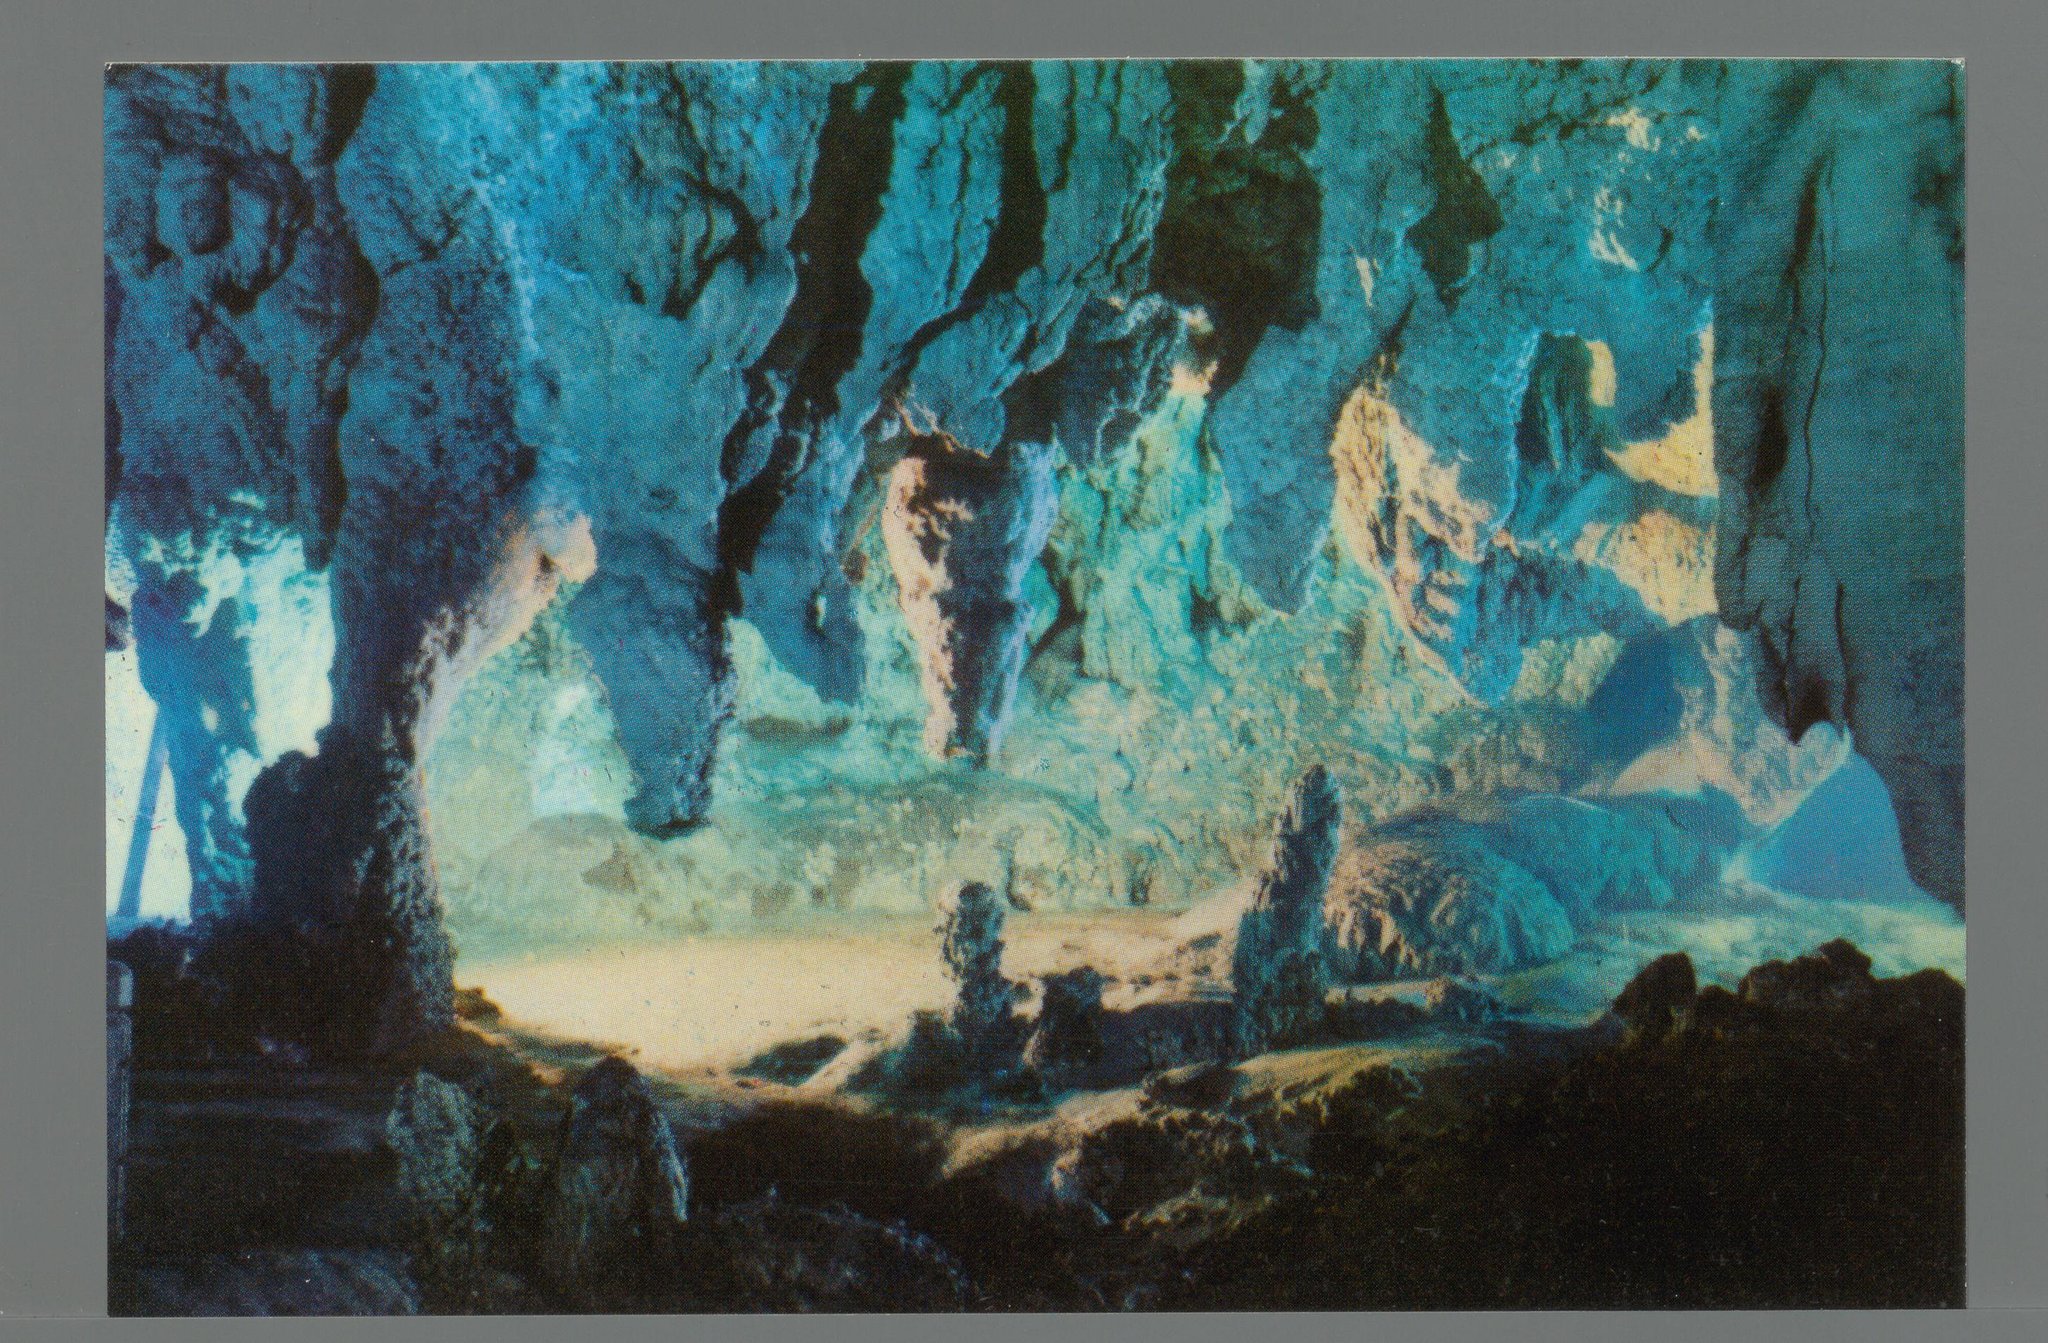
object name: photomechanical print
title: Dripstones in Seven Star Cavern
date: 1974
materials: cardboard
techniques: offset printed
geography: beijing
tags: stalactitic cave